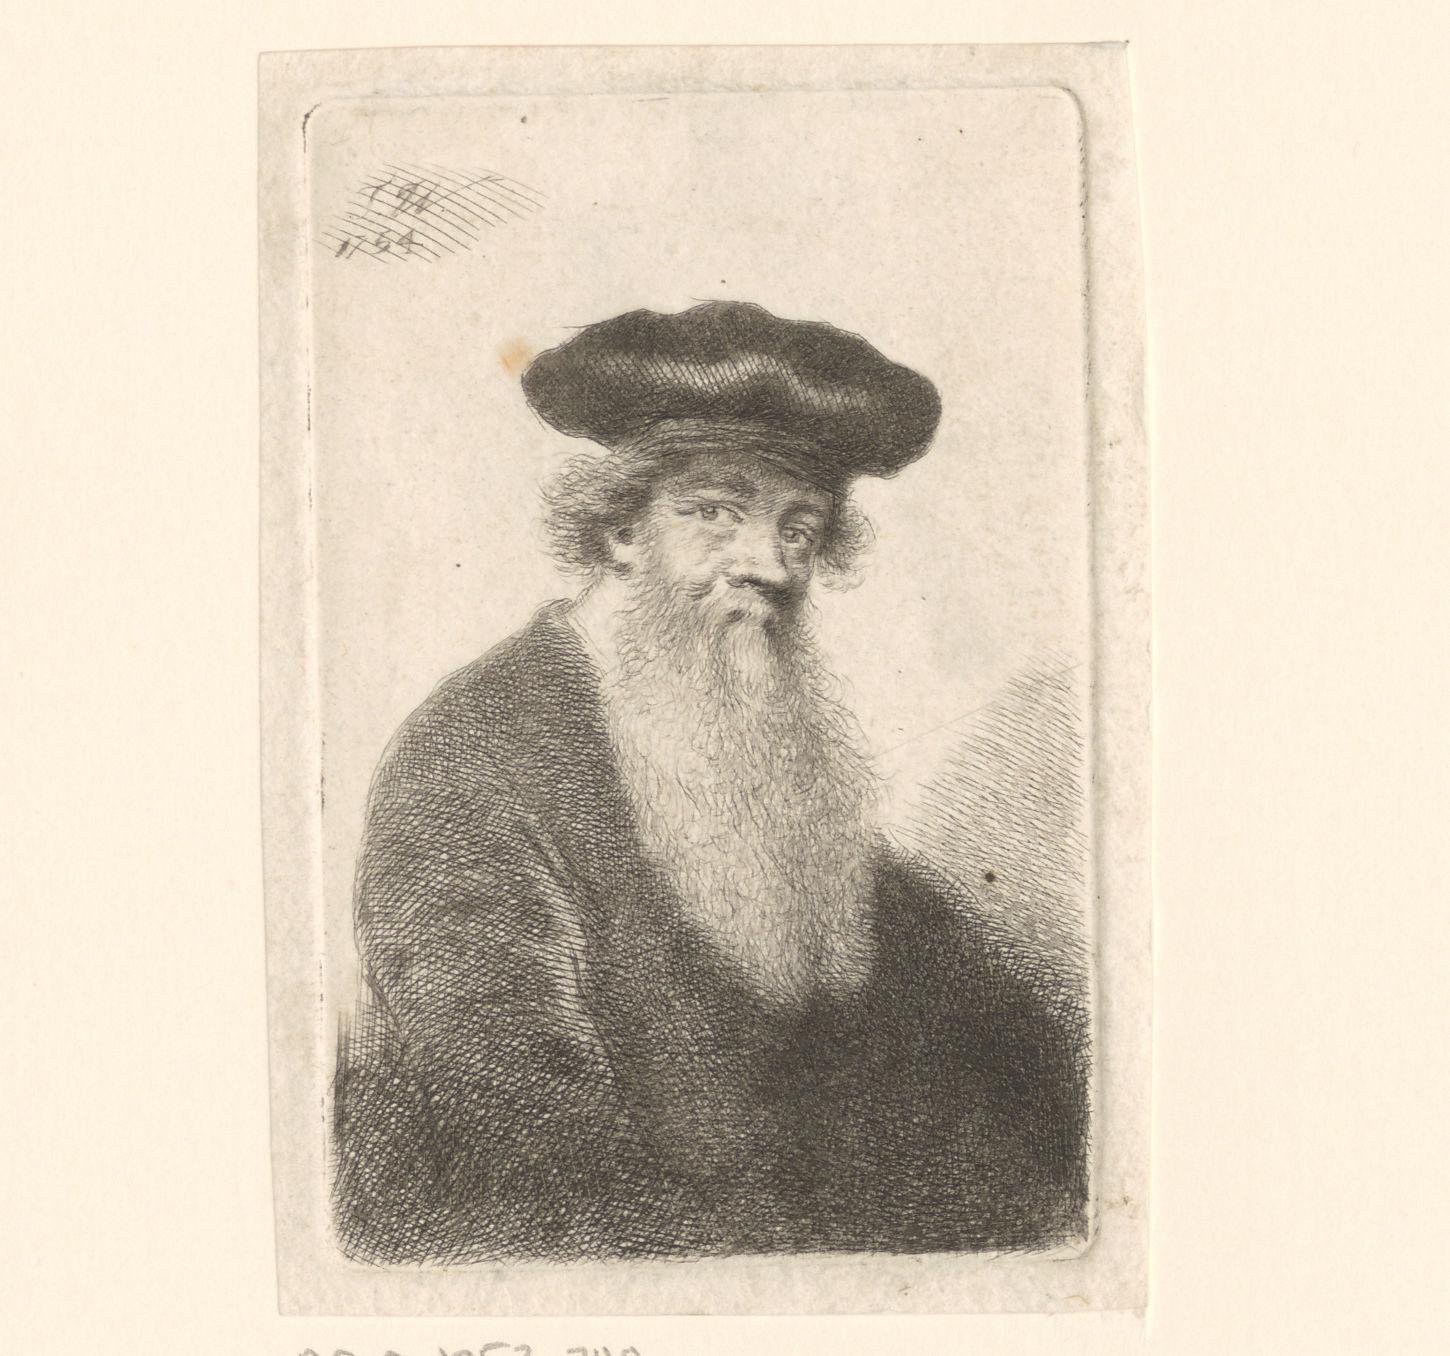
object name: print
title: Portret van Jean-Étienne Liotard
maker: thomas worlidge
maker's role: print maker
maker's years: 1700-1766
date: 1754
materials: paper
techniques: drypoint, etching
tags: painter, jean-etienne liotard, historical person (...) - historical person (...) portrayed alone, portrait, self-portrait of artist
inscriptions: collector's mark: Lugt 2228, collector's mark: Lugt 2760